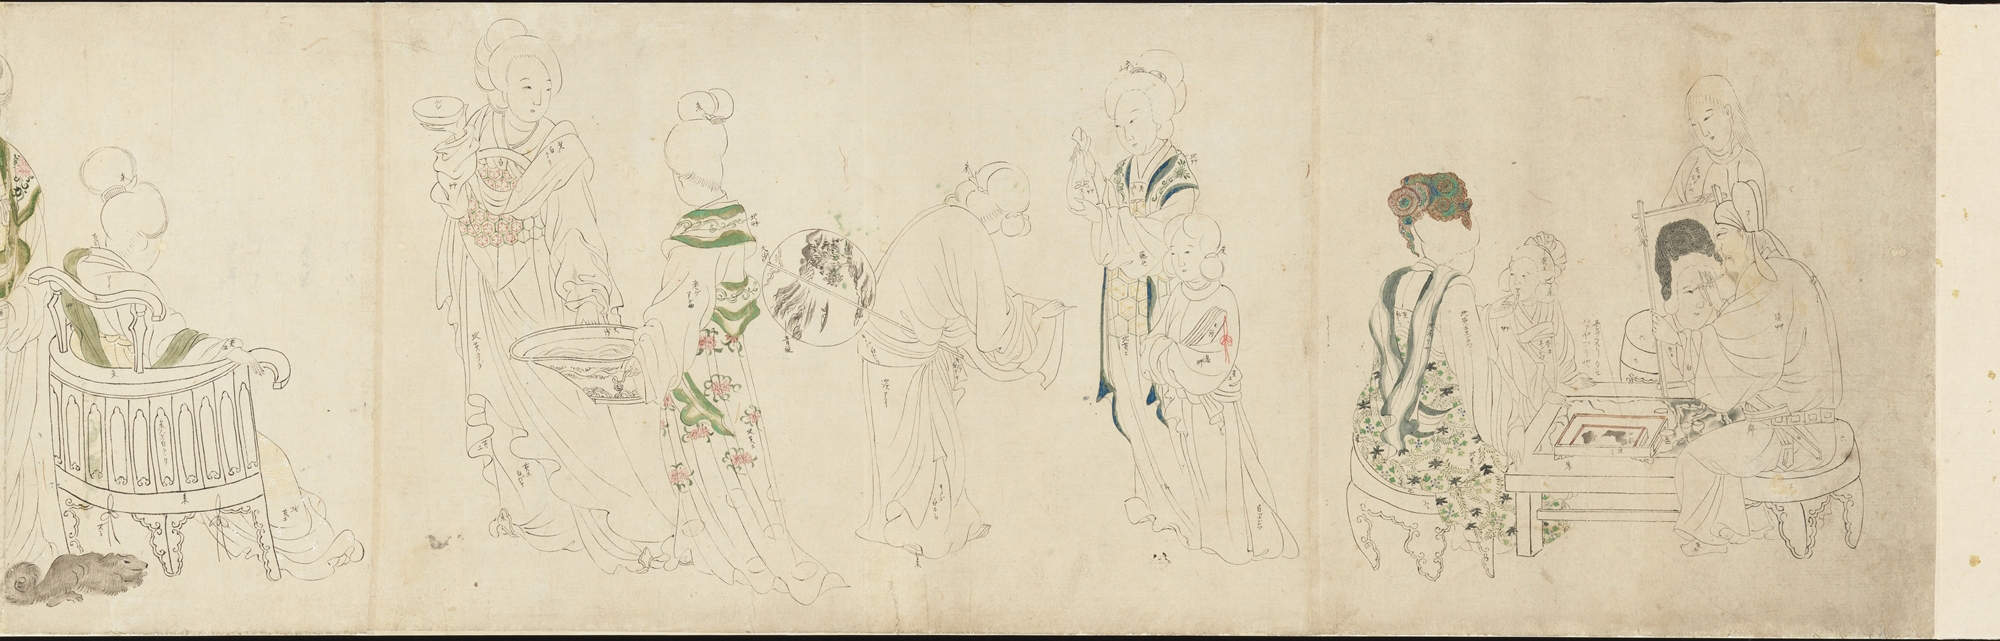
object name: handscroll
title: In the Palace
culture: japanese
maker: unidentified artist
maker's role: artist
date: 1901-1933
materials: ink, paper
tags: painting,children,men,women,dogs